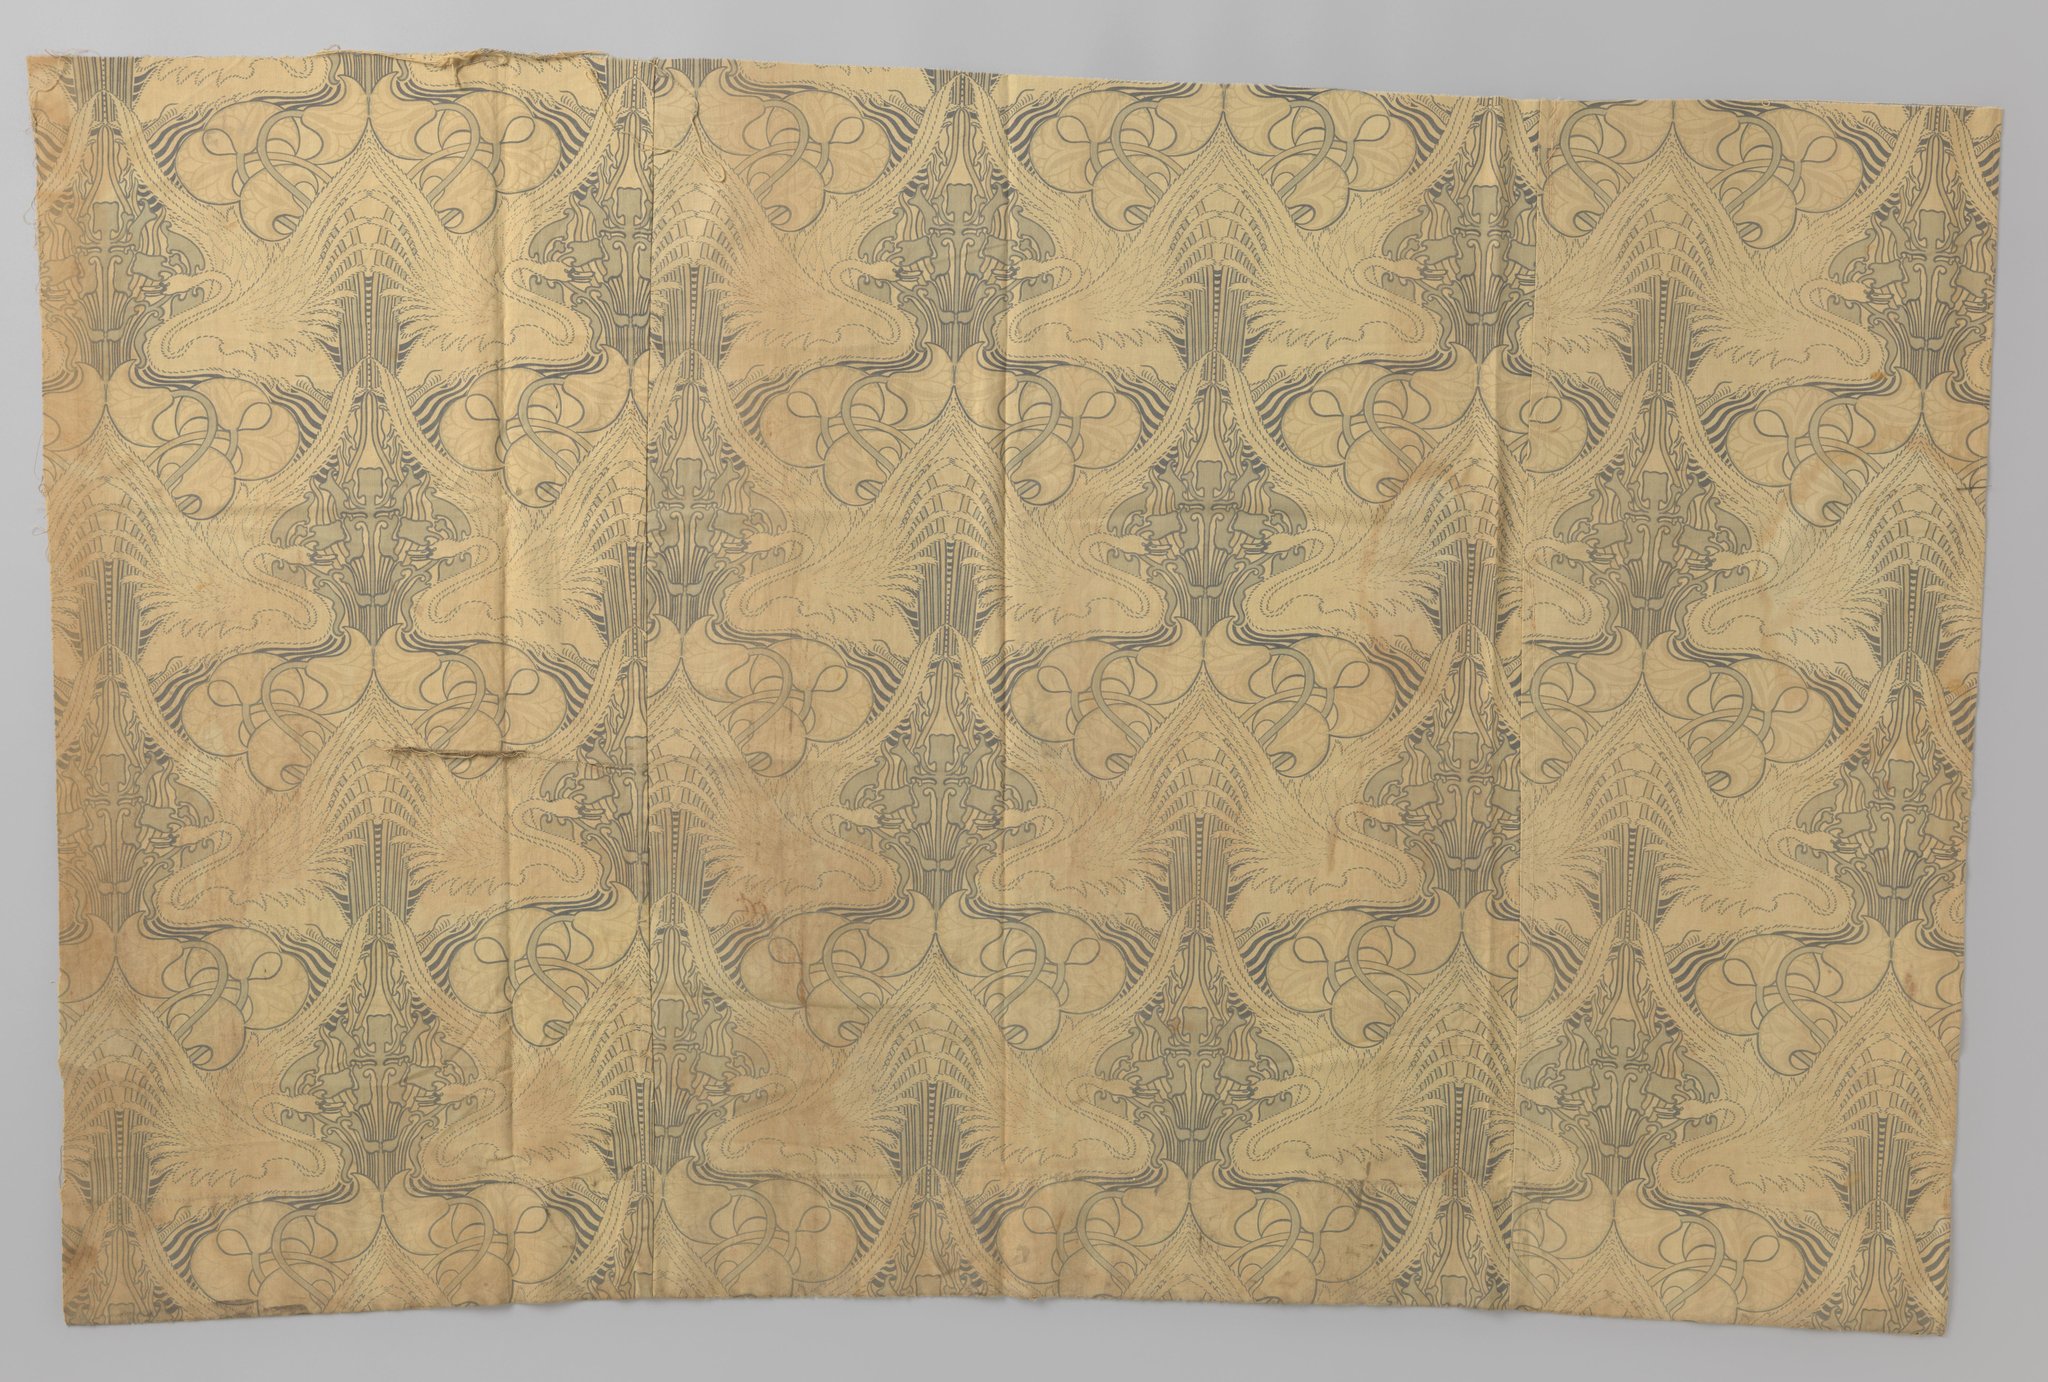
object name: curtain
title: Fragment van een overgordijn van bedrukte cretonne met zwanen en lissen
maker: michiel duco crop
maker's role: designer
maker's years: 1862-1901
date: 1900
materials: linen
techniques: printing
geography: helmond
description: Fragment van een overgordijn van bedrukte cretonne met zwanen en lissen.